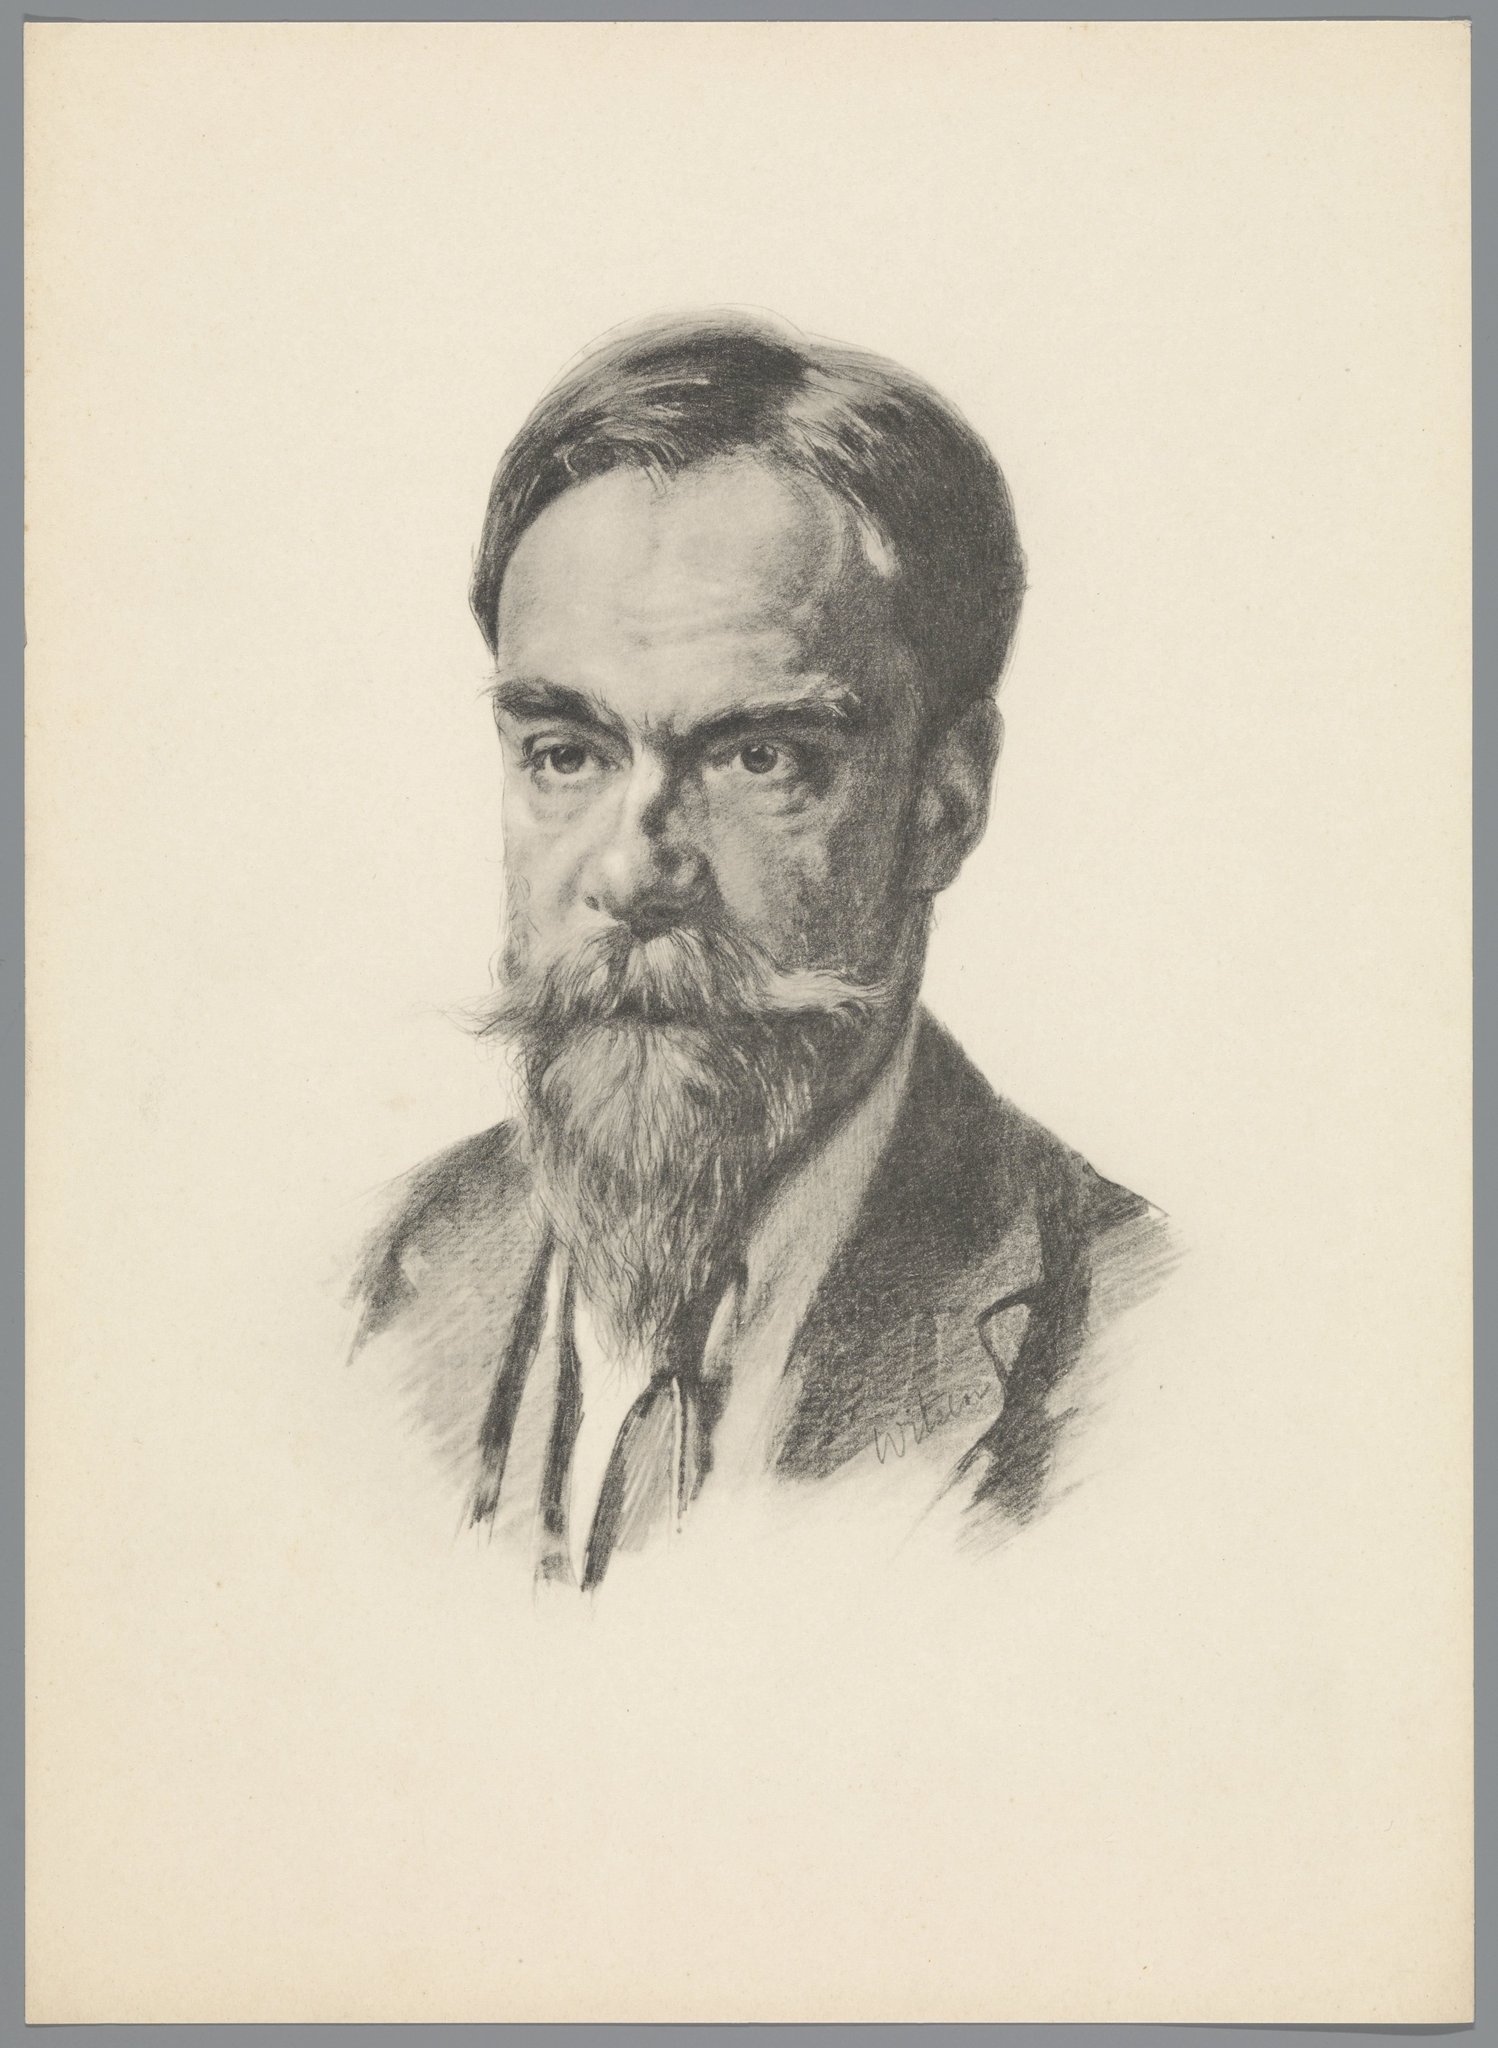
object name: print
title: Reproductie naar krijttekening met portret van Frans Coenen Jr.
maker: Anonymous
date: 1860-1915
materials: paper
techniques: photograph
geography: netherlands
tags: frans coenen (1866-1936)